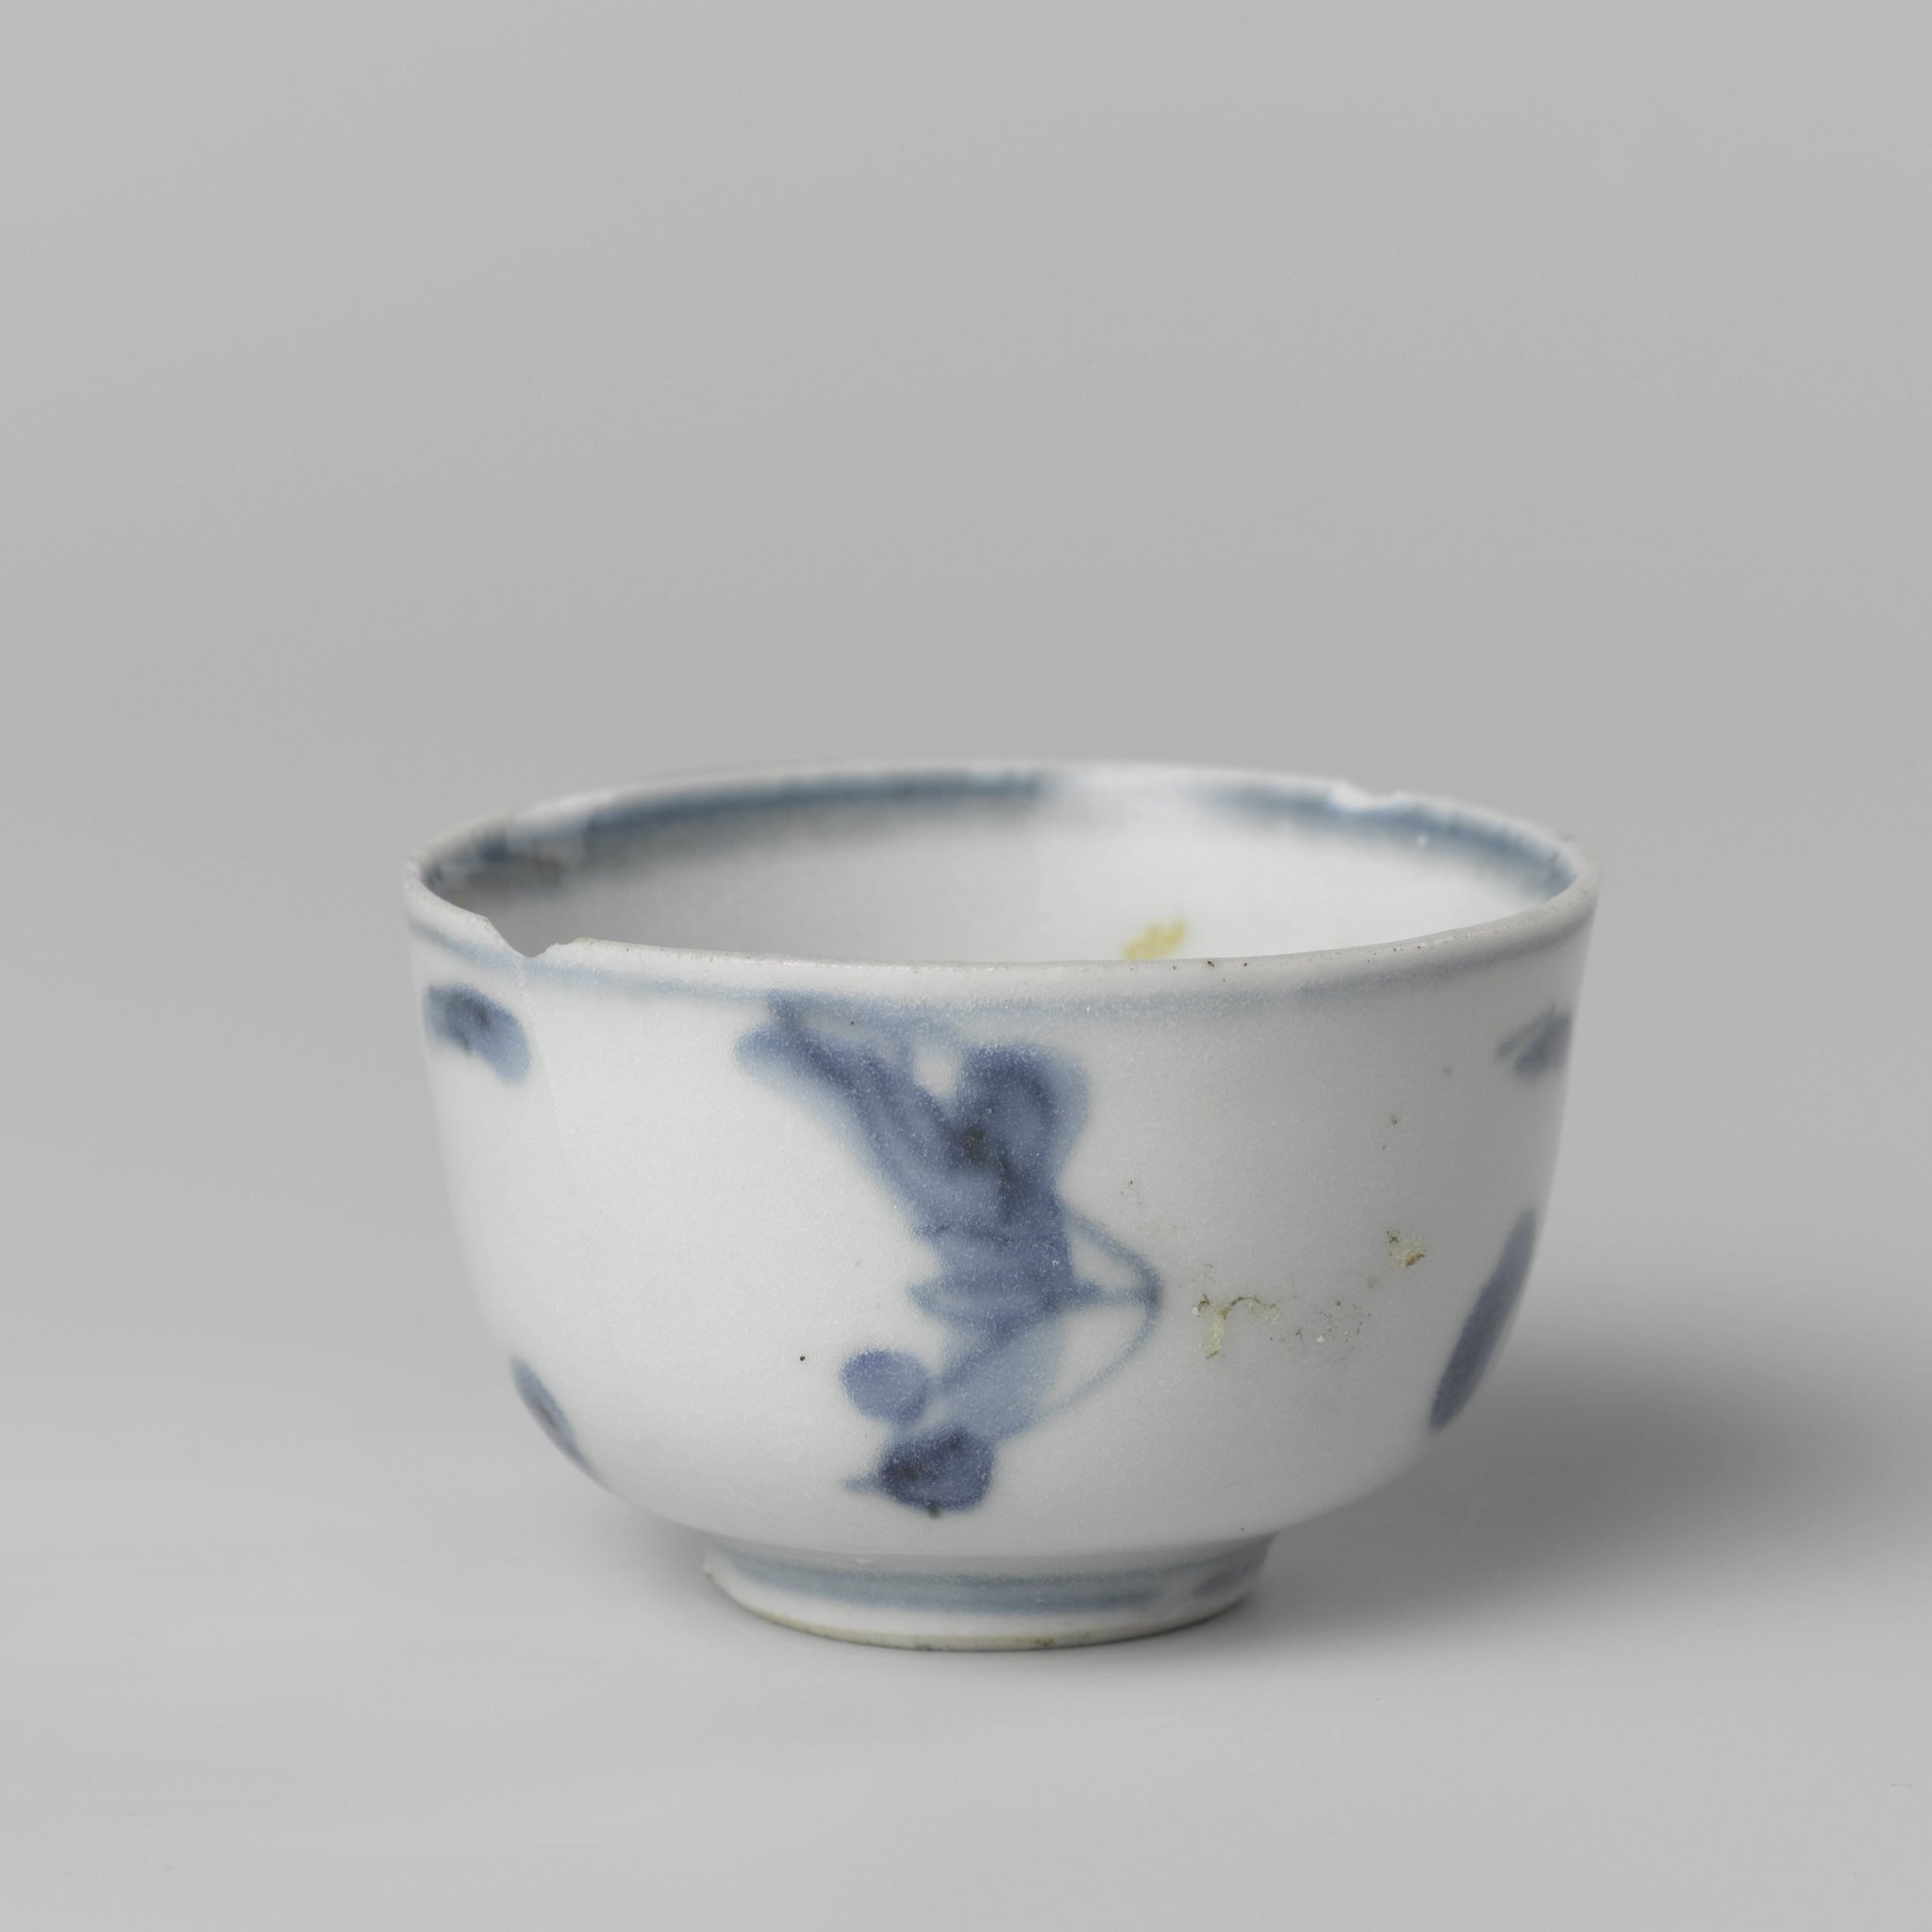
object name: wine cup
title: Kom uit V.O.C.-schip de 'Witte Leeuw'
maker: Anonymous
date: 1613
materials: porcelain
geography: jingdezhen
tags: verenigde oostindische compagnie, sint-helena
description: A winecup. In the centre an indistinguishable mark is drawn. Around the flat and lip-rim there is a single band. On the outside four dancing figures ('zotjes'?) are sketched with in between two blotches. NB the bottom is unglazed.